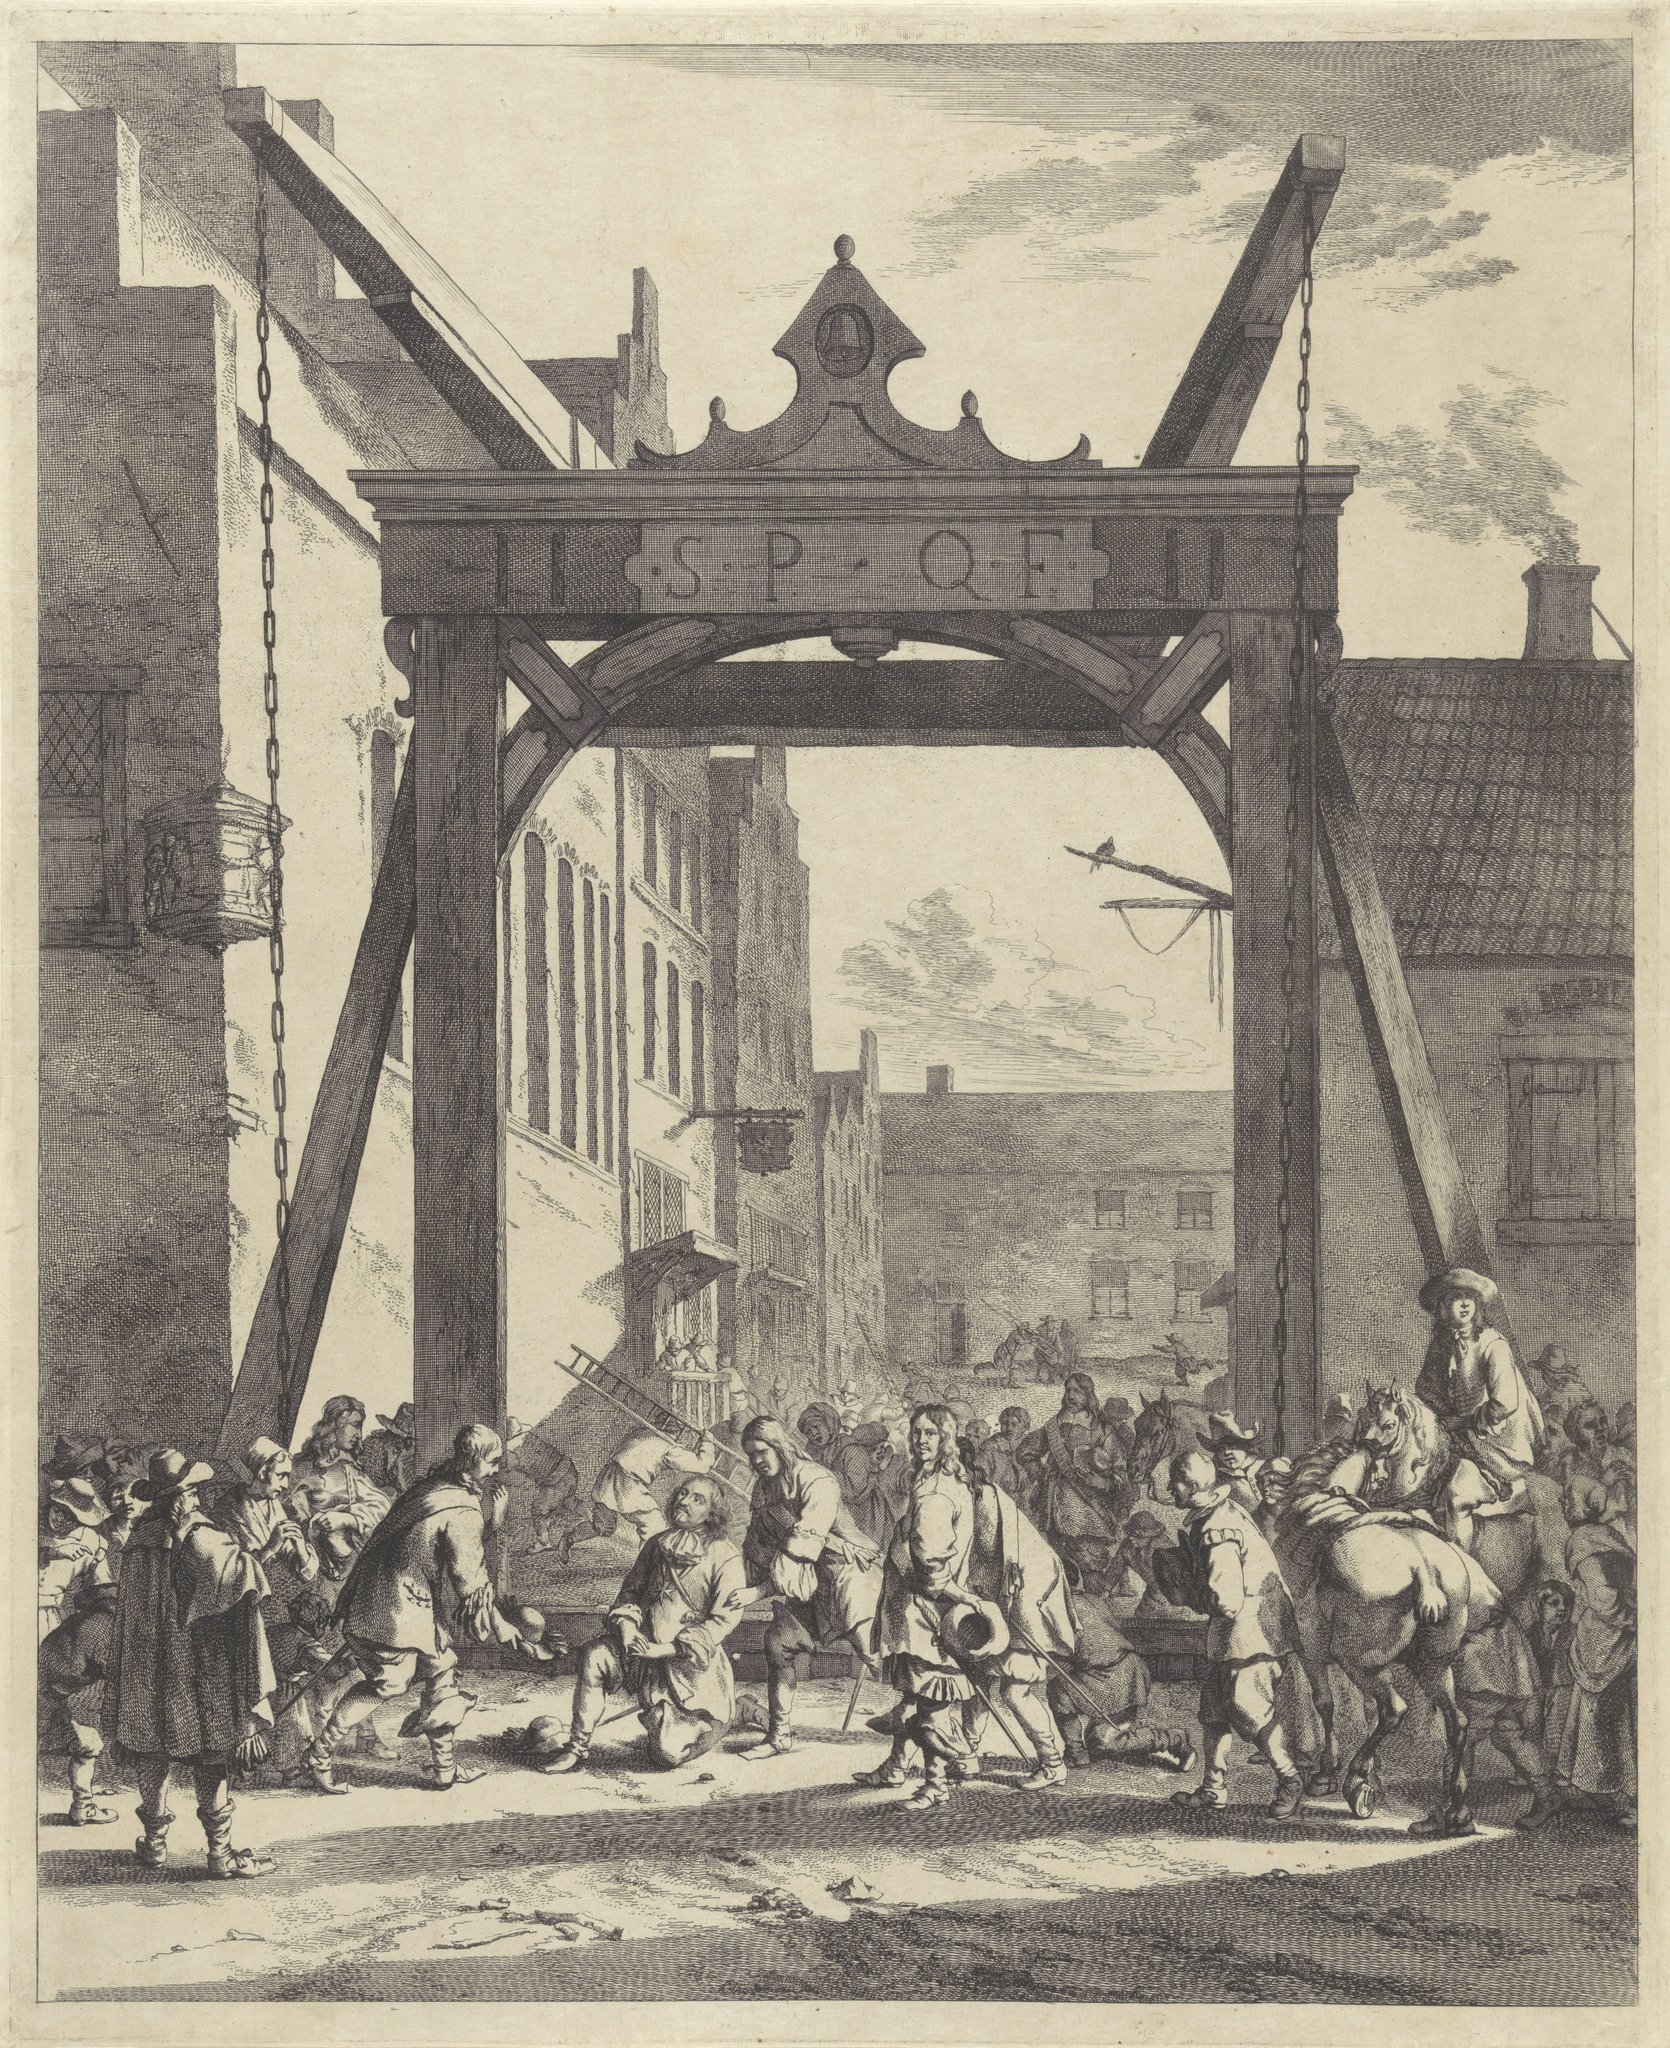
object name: print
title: Dankzegging door graaf Johan Maurits na het ongeluk op de brug van Franeker, 1665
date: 1665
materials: paper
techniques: etching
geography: northern netherlands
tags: earl, johan maurits graaf van nassau-siegen, collapsing building, bridge, accident with horse (or kindred animal), one person praying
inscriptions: collector's mark: Lugt 2165, collector's mark: Lugt 573, collector's mark: Lugt 12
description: Dankzegging door graaf Johan Maurits na zijn redding na het ongeluk op de brug van Franeker, 1665, 6 januari 1665. De graaf knielt bij de ingestorte ophaalbrug.